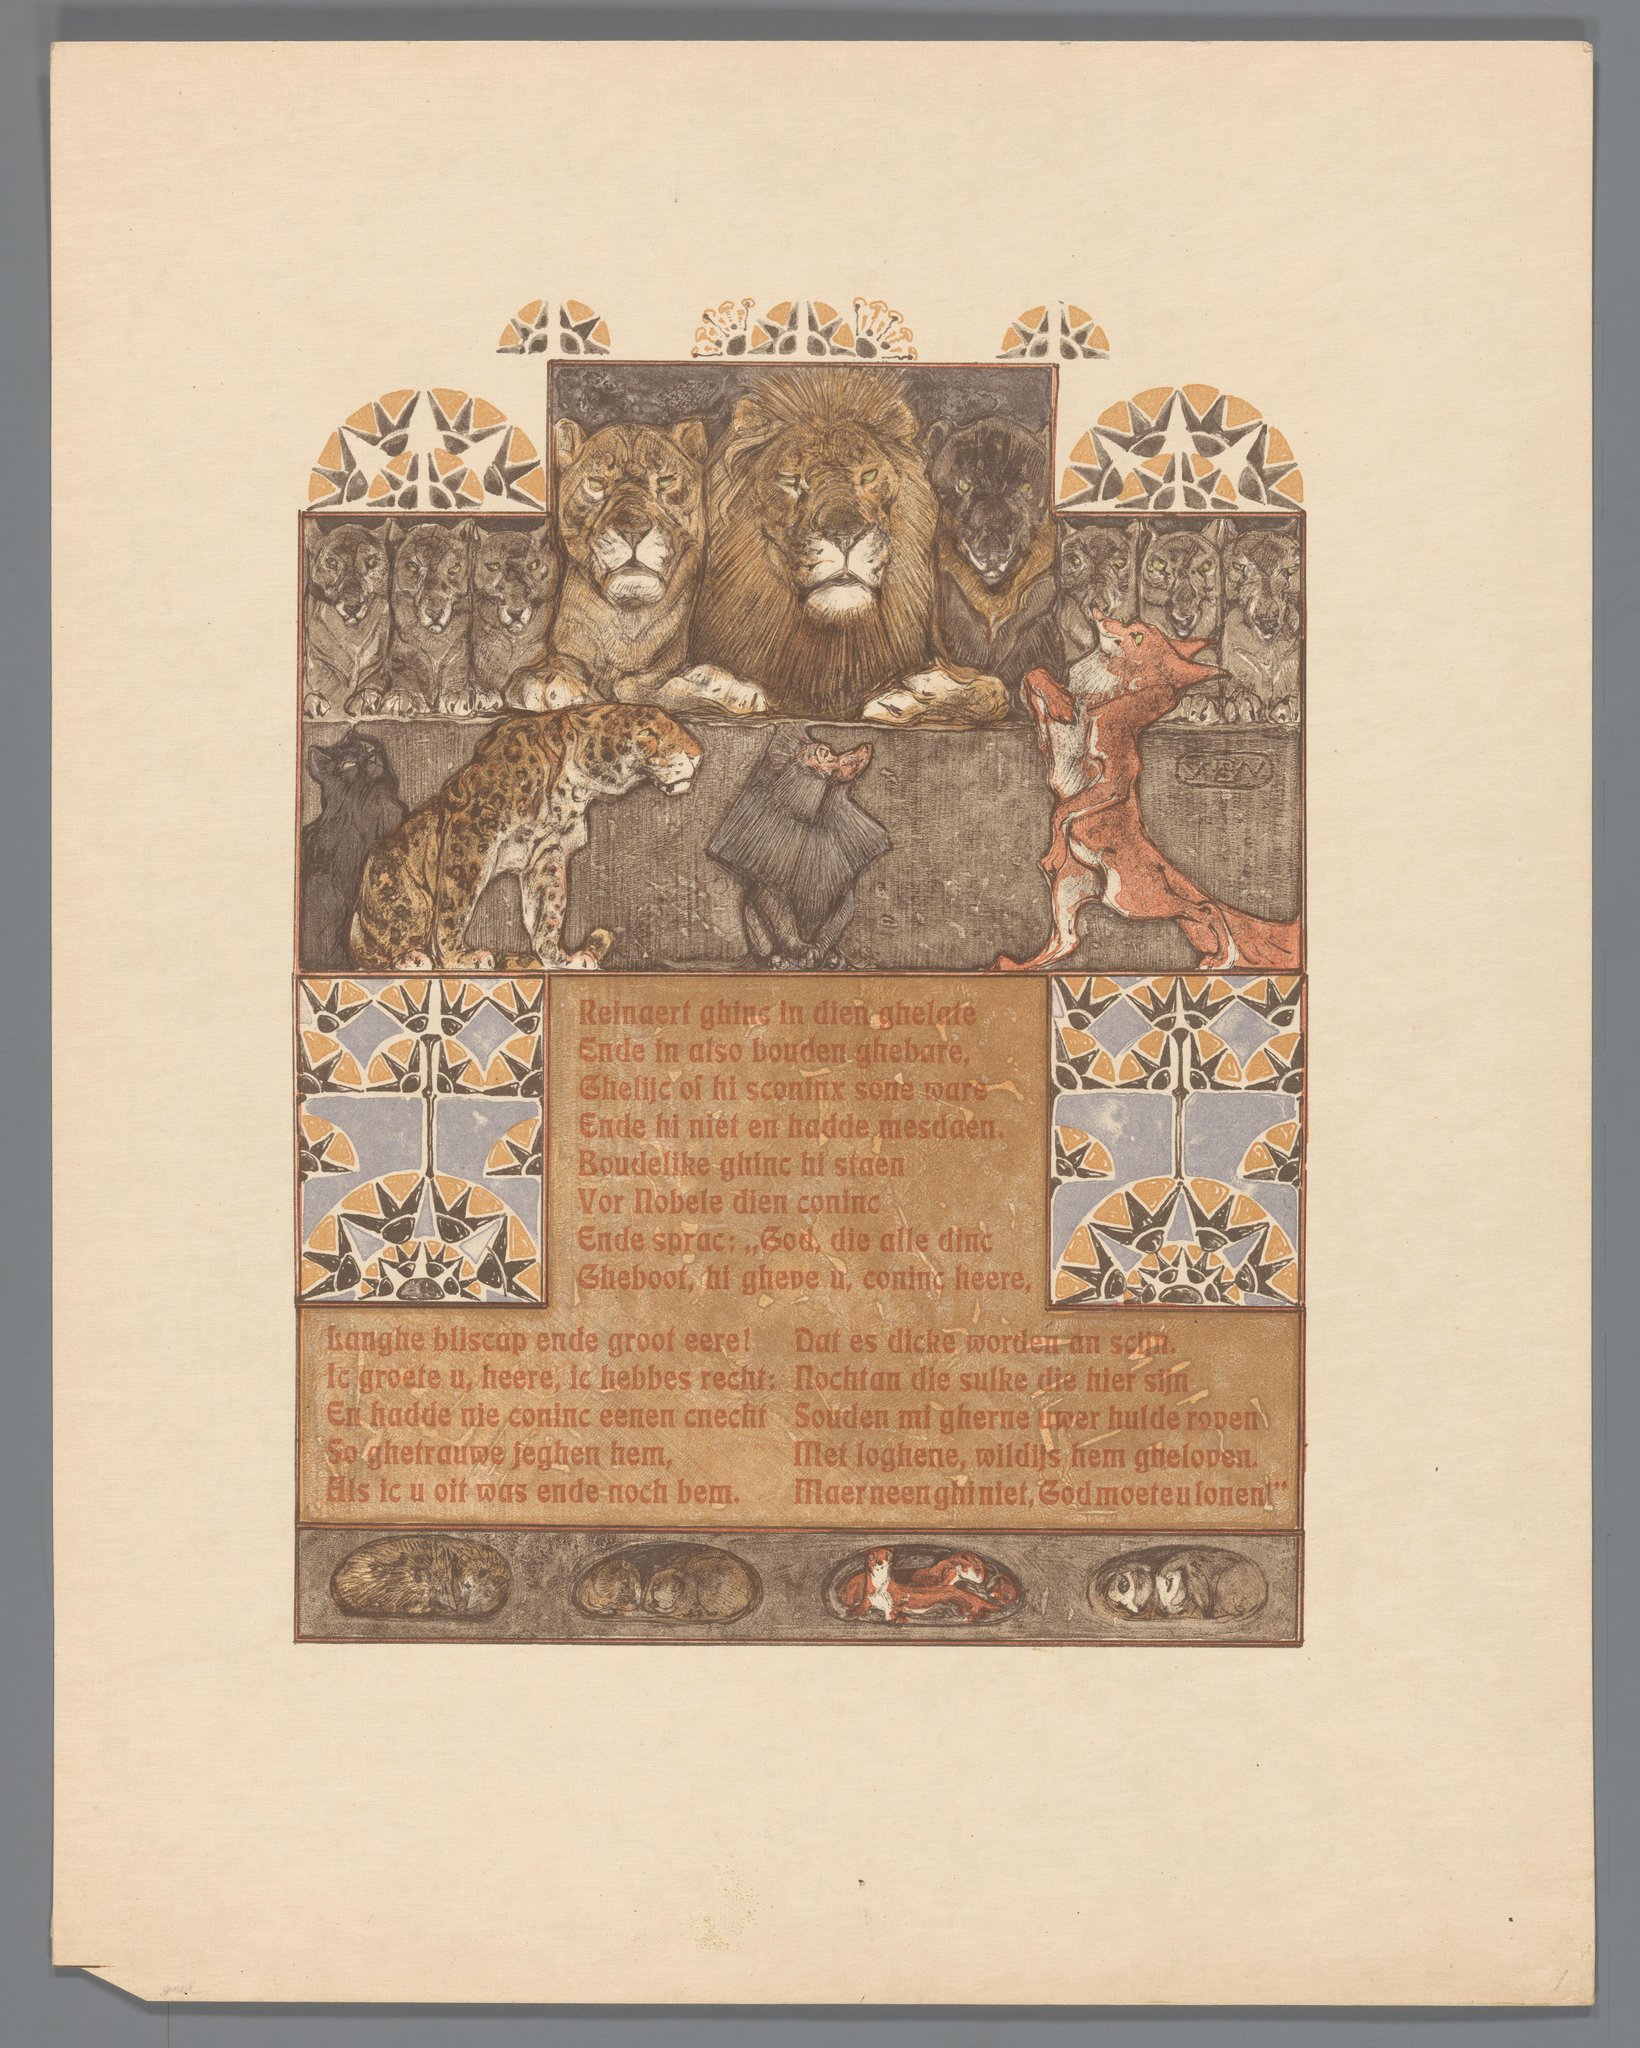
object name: print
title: Vos (Reinaert) voor leeuw (Nobel) en andere dieren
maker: bernard willem wierink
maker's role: draughtsman, print maker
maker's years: 1856-1939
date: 1910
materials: paper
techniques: lithograph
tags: fable of reynard the fox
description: Prent gebruikt in: Streuvels, Stijn (Frank Lateur). Reinaert de Vos naar verschillende uitgaven van het middeleeuwsche epos. Amsterdam: L.J. Veen, 1910.